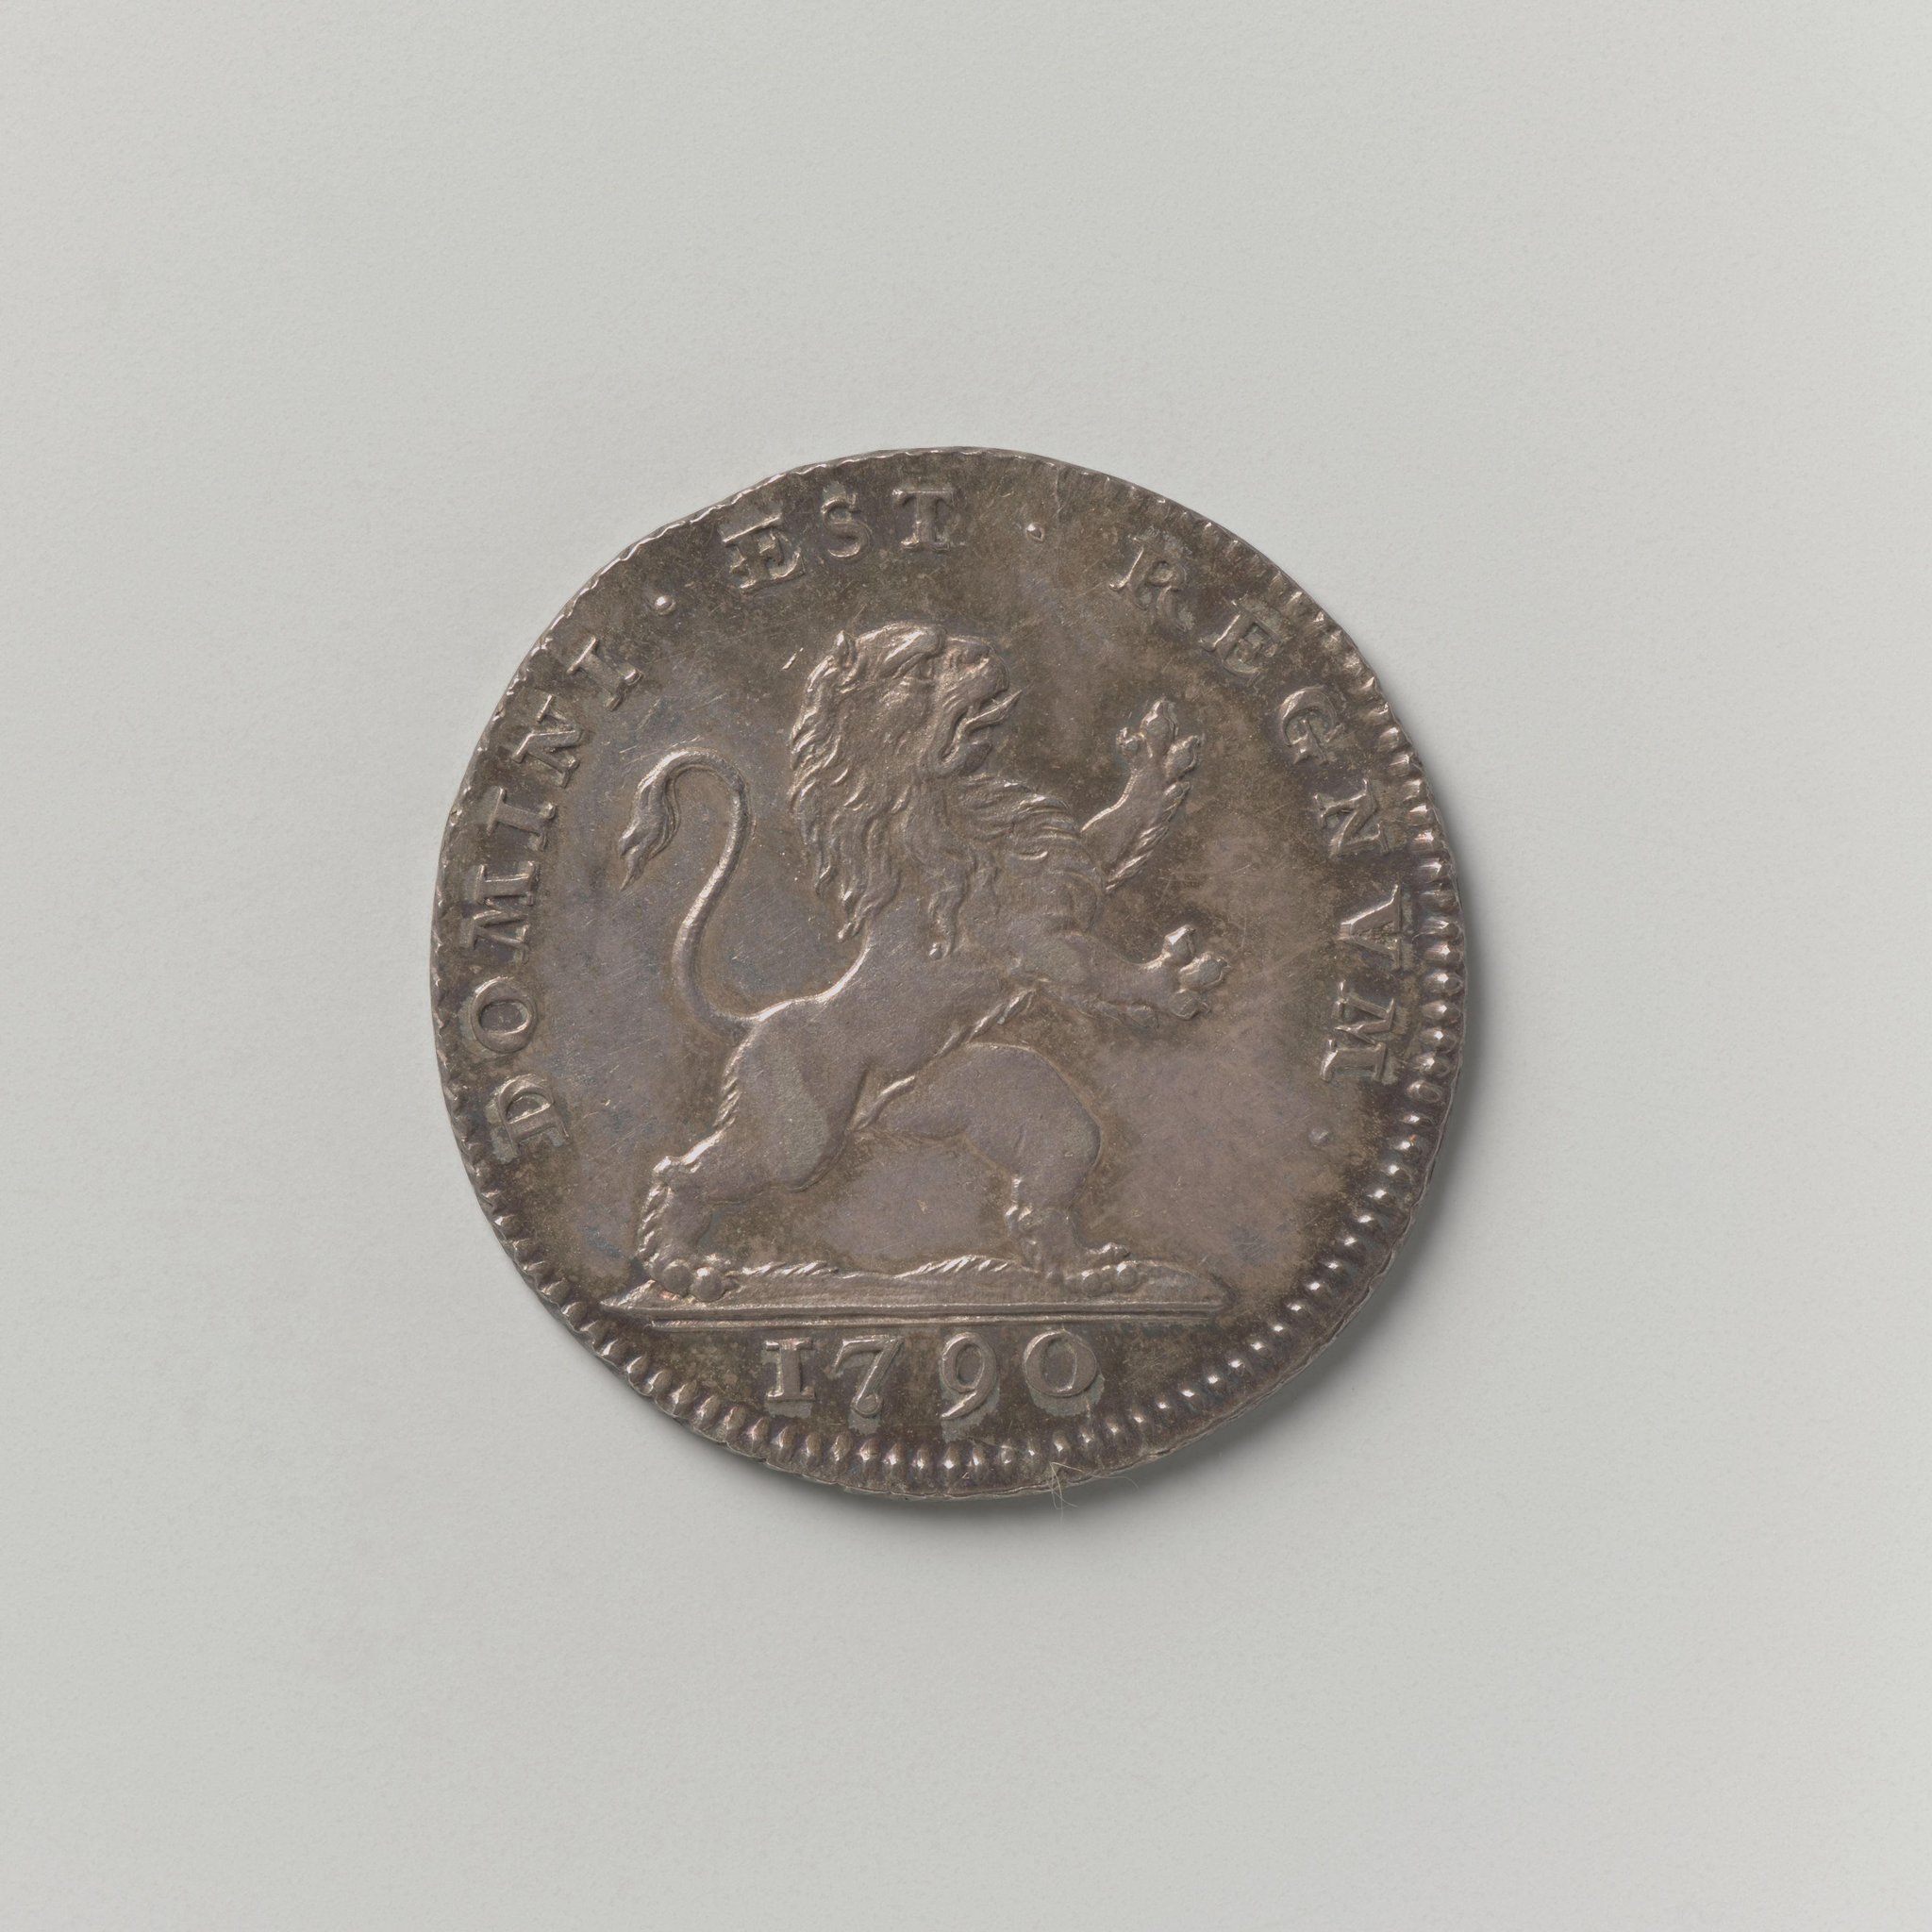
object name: coin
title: 10 stuiver van de Verenigde Belgische Staten, 1790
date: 1790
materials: silver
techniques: striking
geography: brussels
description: Zilveren munt. Voorzijde: staande leeuw naar rechts. Jaartal in afsnede. Keerzijde: twee uit wolken komende ineengeslagen handen, waarin pijlenbundel. In afsnede waarde-aanduiding. Engelenkop aan het eind van het omschrift. Kabelrand.